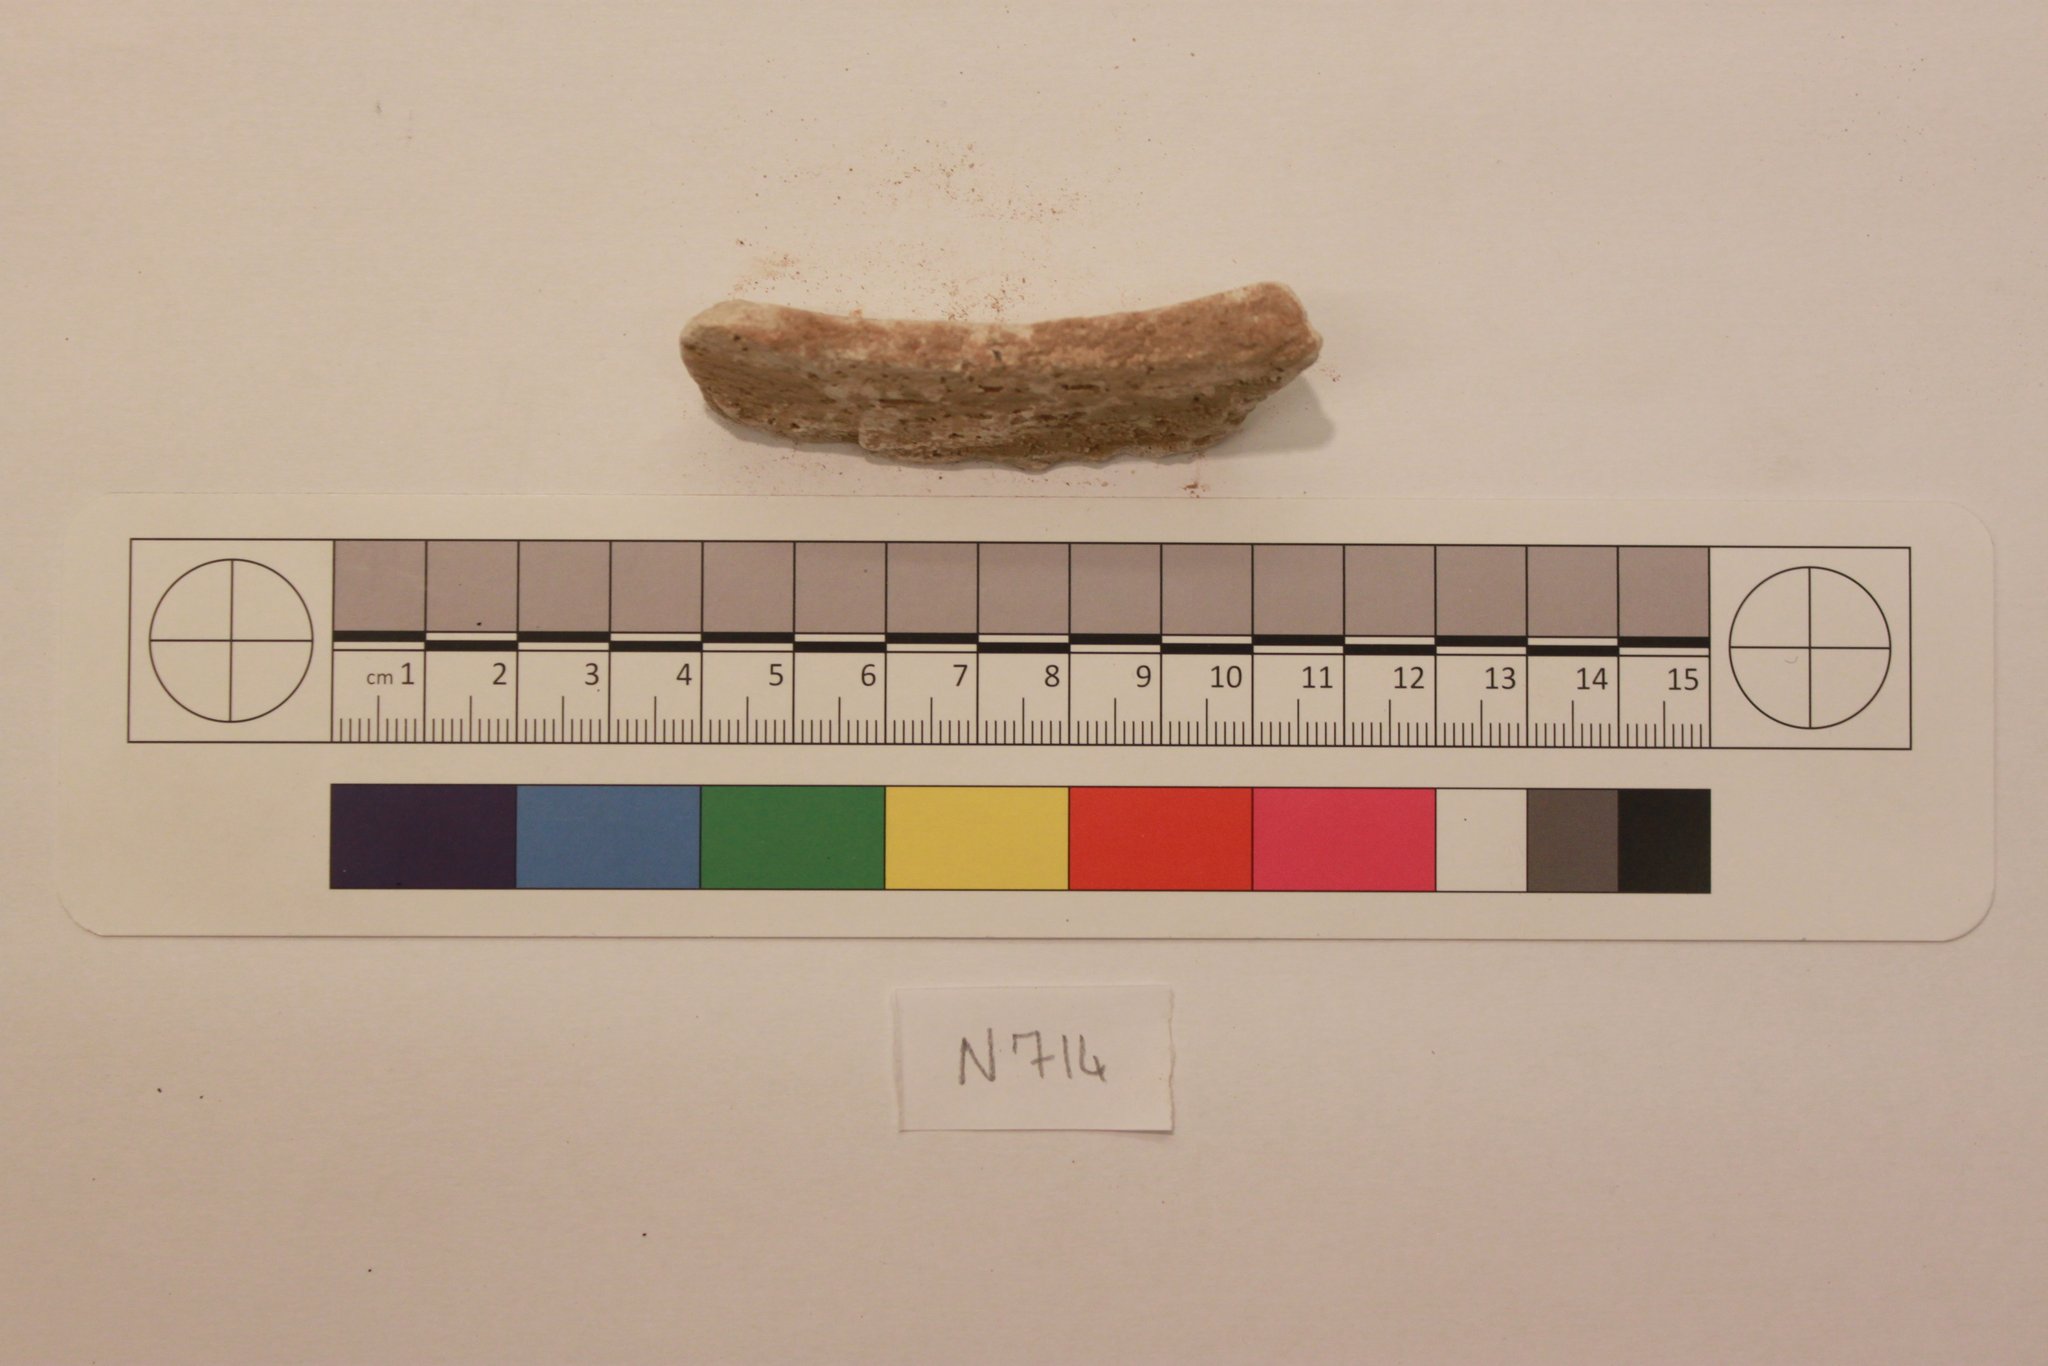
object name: fragment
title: Stucco Fragment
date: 701-1200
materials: plaster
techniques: carving, painting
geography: iran